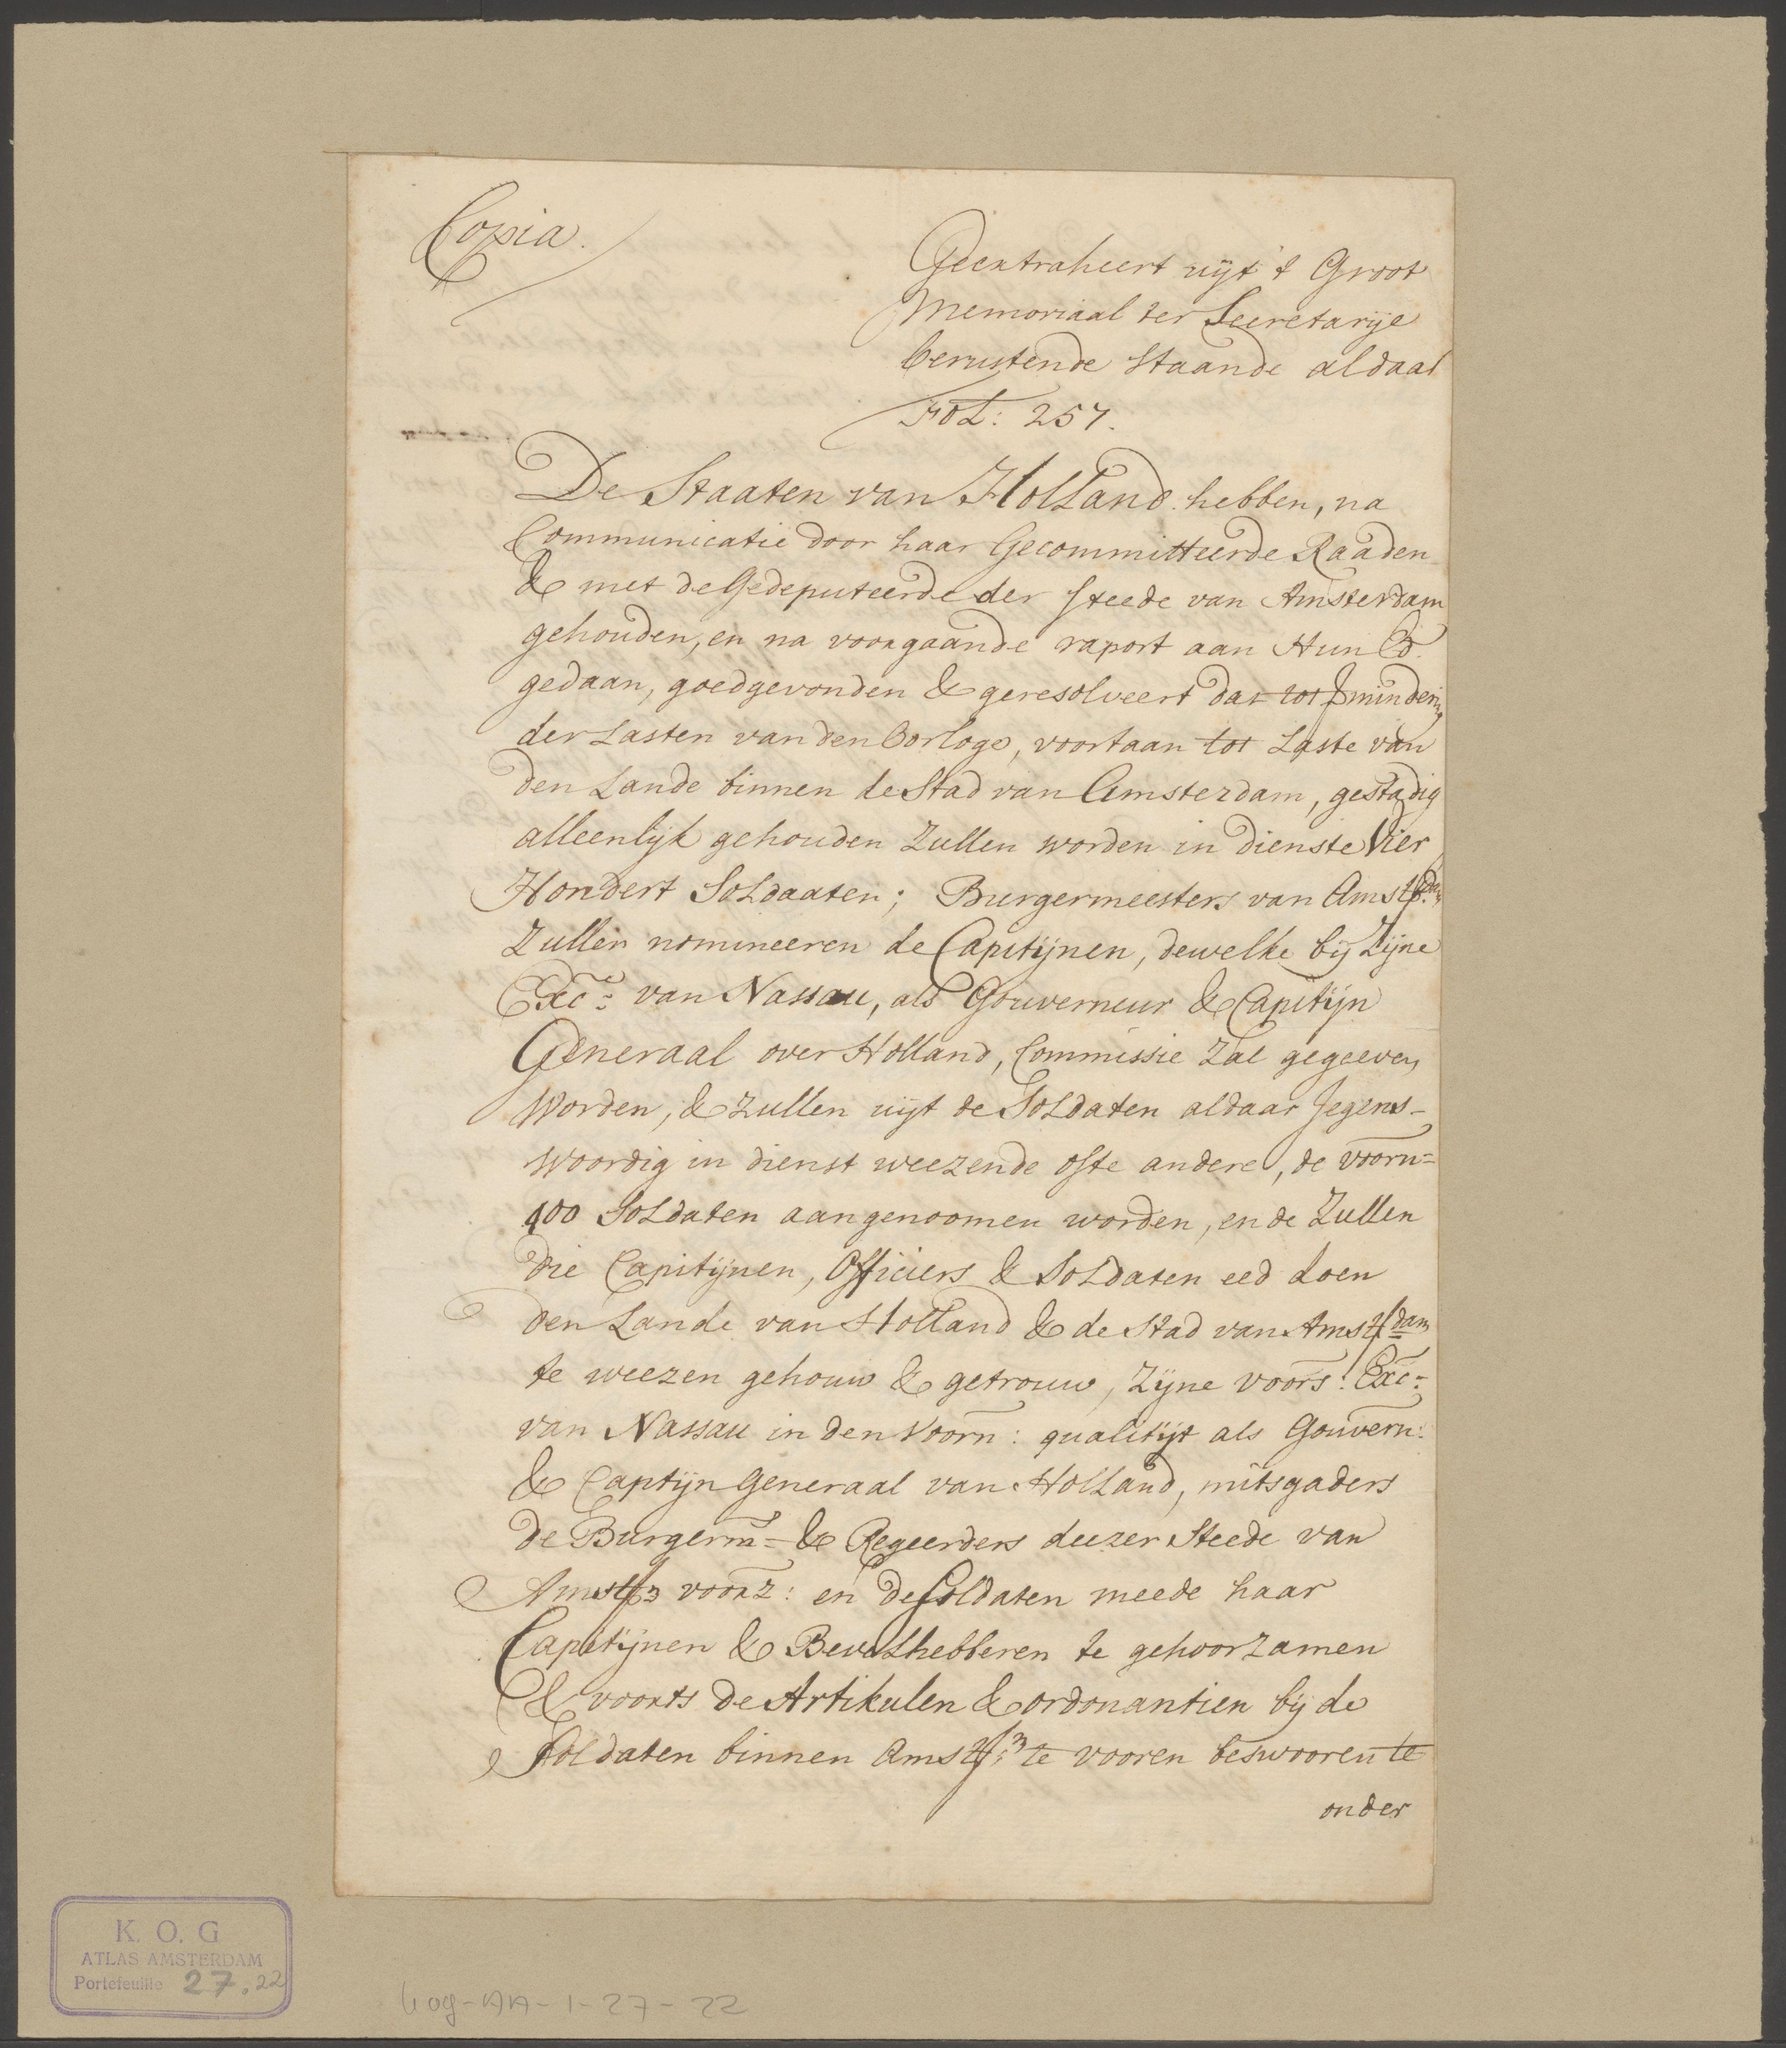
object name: document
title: Extract uijt 't Groot Memoriaal ter Secretarij berustende, Aangaande de aanstelling van de Compagnien der Soldaten dezer Steede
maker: Anonymous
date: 1701-1800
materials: ink, paper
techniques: pen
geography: northern netherlands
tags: military service, the hague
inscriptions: collector's mark: Lugt 1641b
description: Onderwerpsrubriek binnen de Atlas Amsterdam: Landmacht: Gebouwen / Herinneringen aan officieren, stadssoldaten / Nationale militie / (diverse korpsen) / Padvinders / Parade.